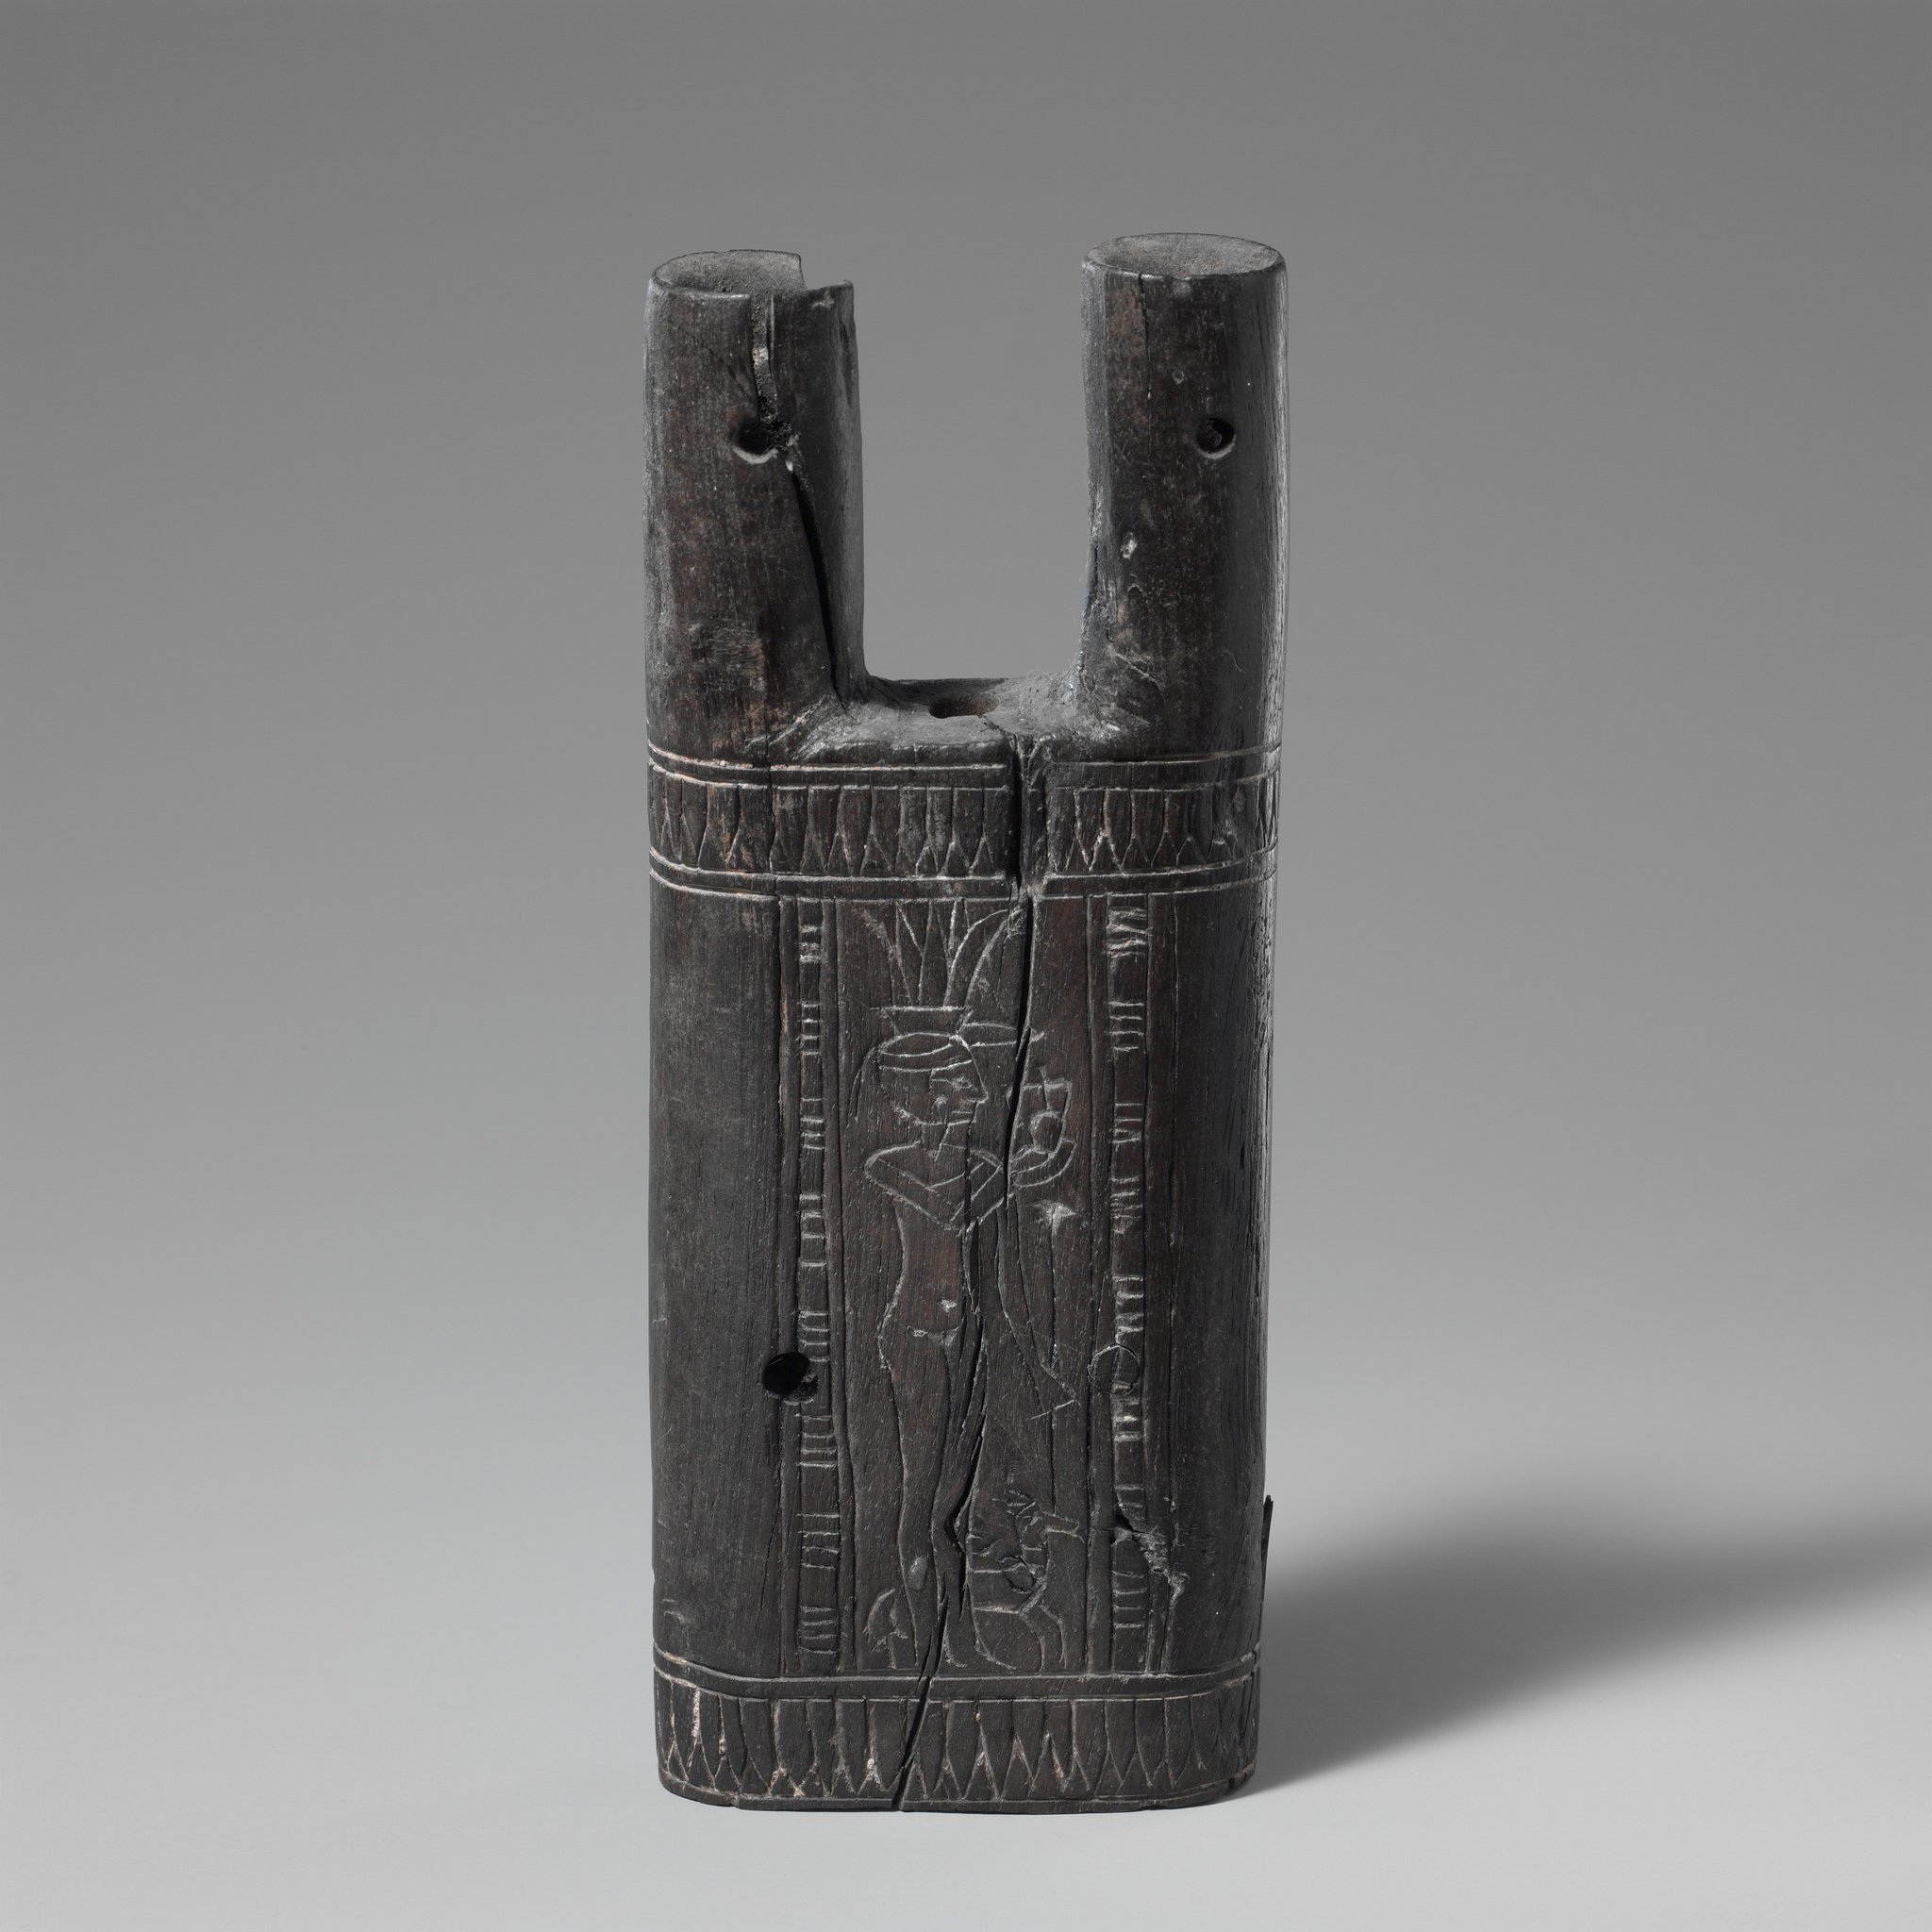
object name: kohl tube, double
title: Double Kohl Tube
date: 1400-1200 BCE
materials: wood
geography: egypt